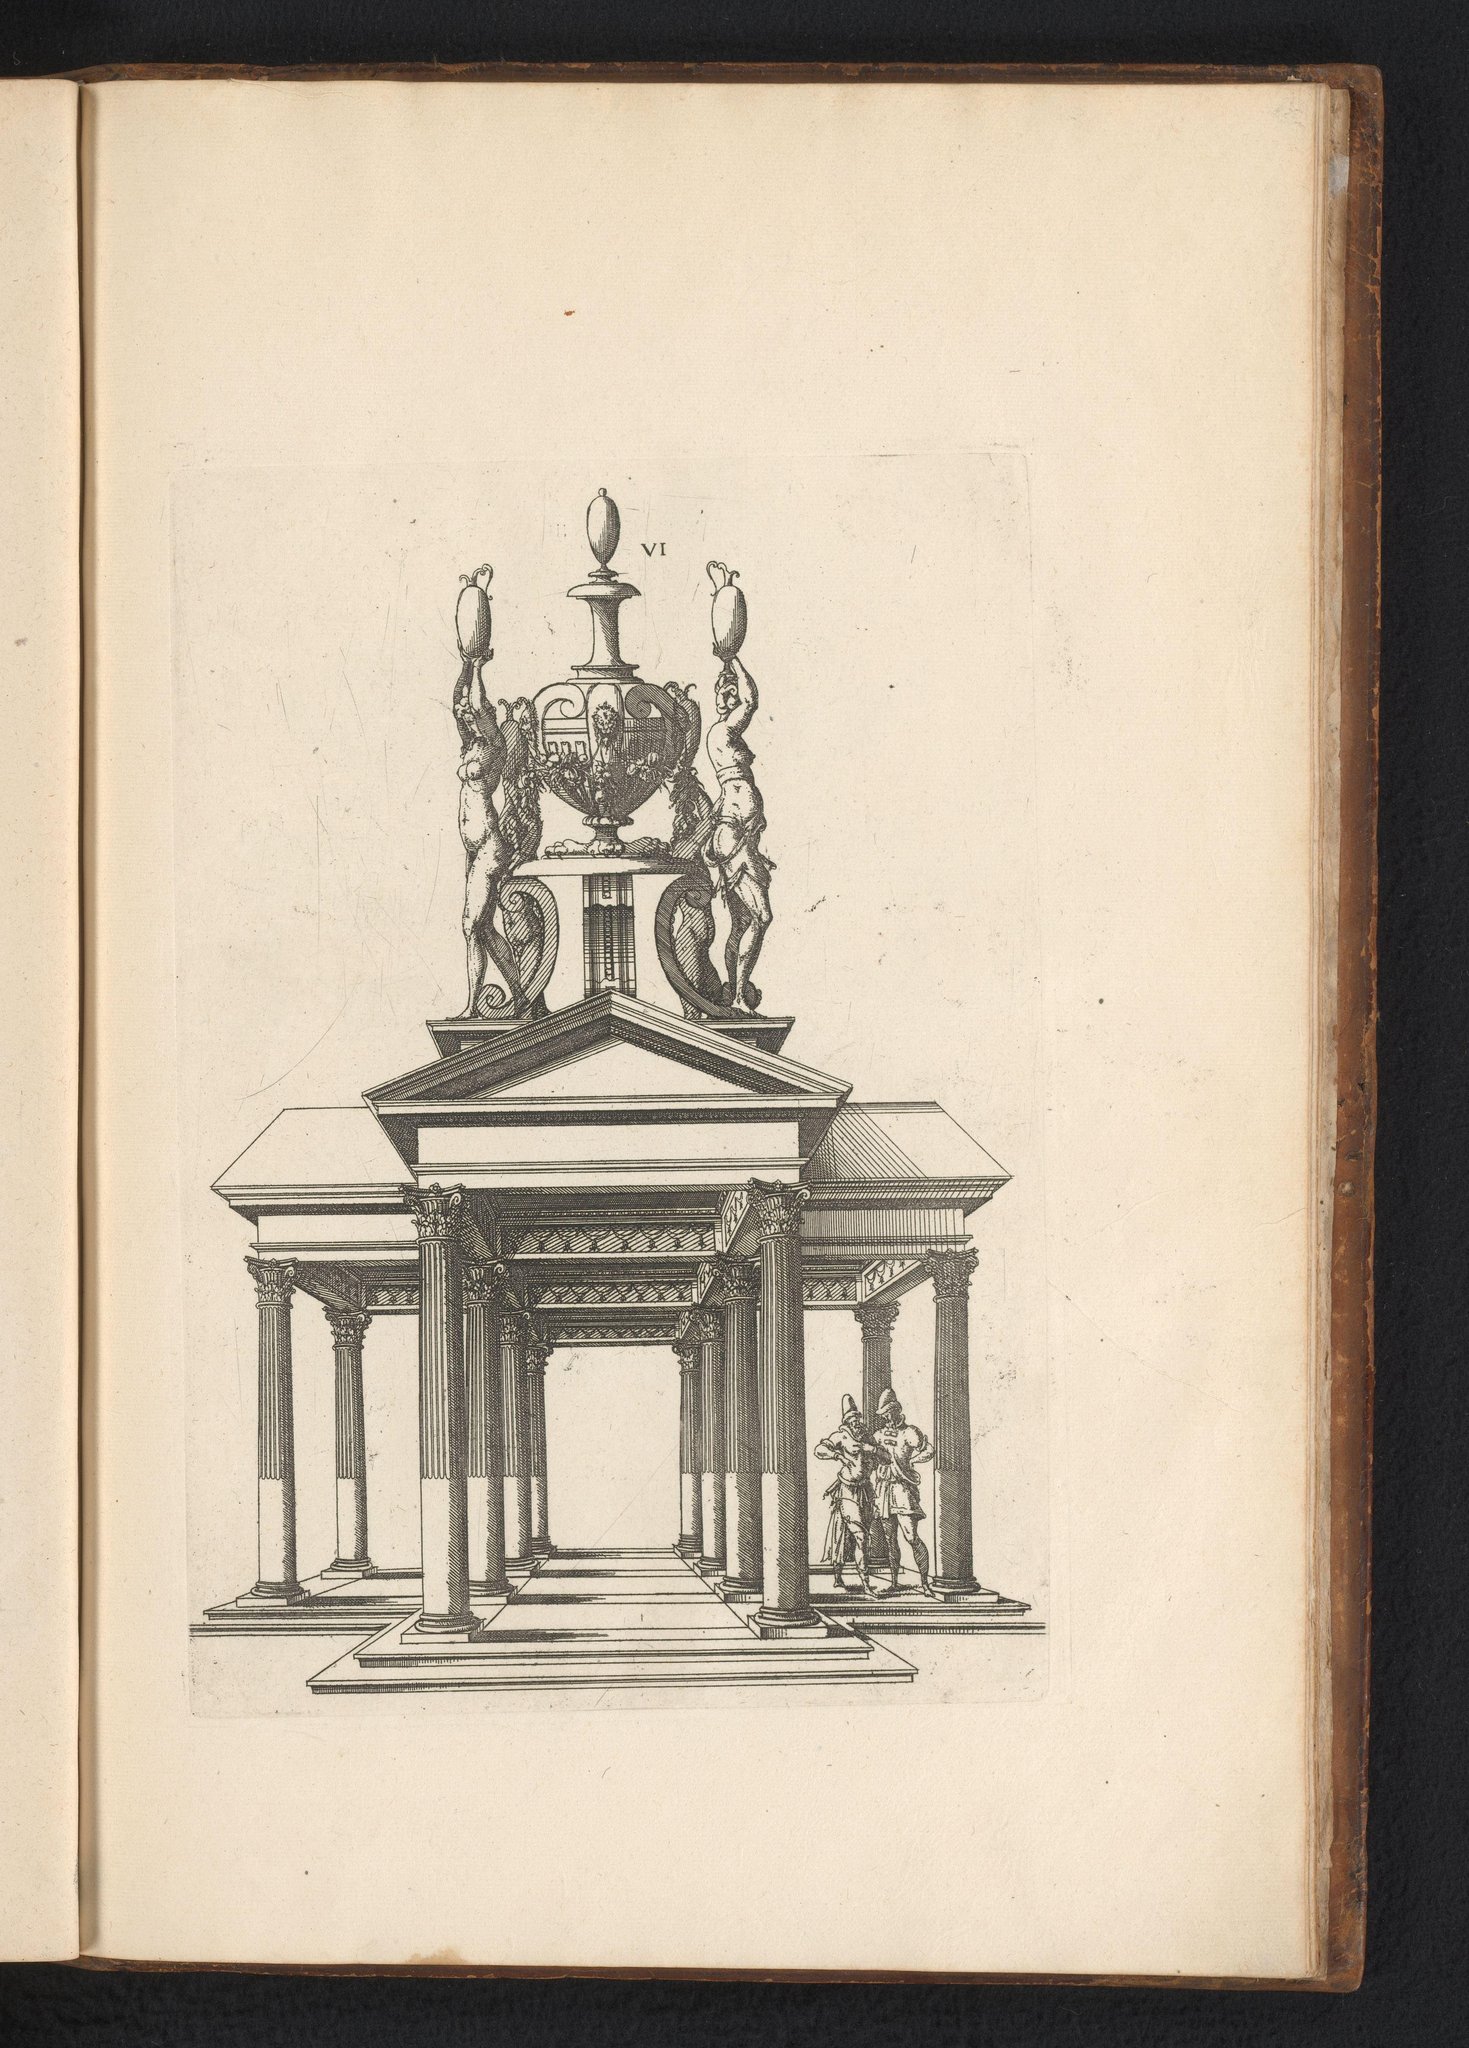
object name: ornament print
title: Kruisvormig gebouw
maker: jacques androuet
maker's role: draughtsman, print maker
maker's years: 1515-1584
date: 1561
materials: paper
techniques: etching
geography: paris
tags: column, pillar ~ architecture, architectural design or model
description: Kruisvormig open paviljoen, het dak gedragen door zuilen. Met twee mannen. Genummerd: VI. Onderdeel van 'Seconde livre d'architectvre' (1561): 64 etsen met geornamenteerde architectuuronderdelen.